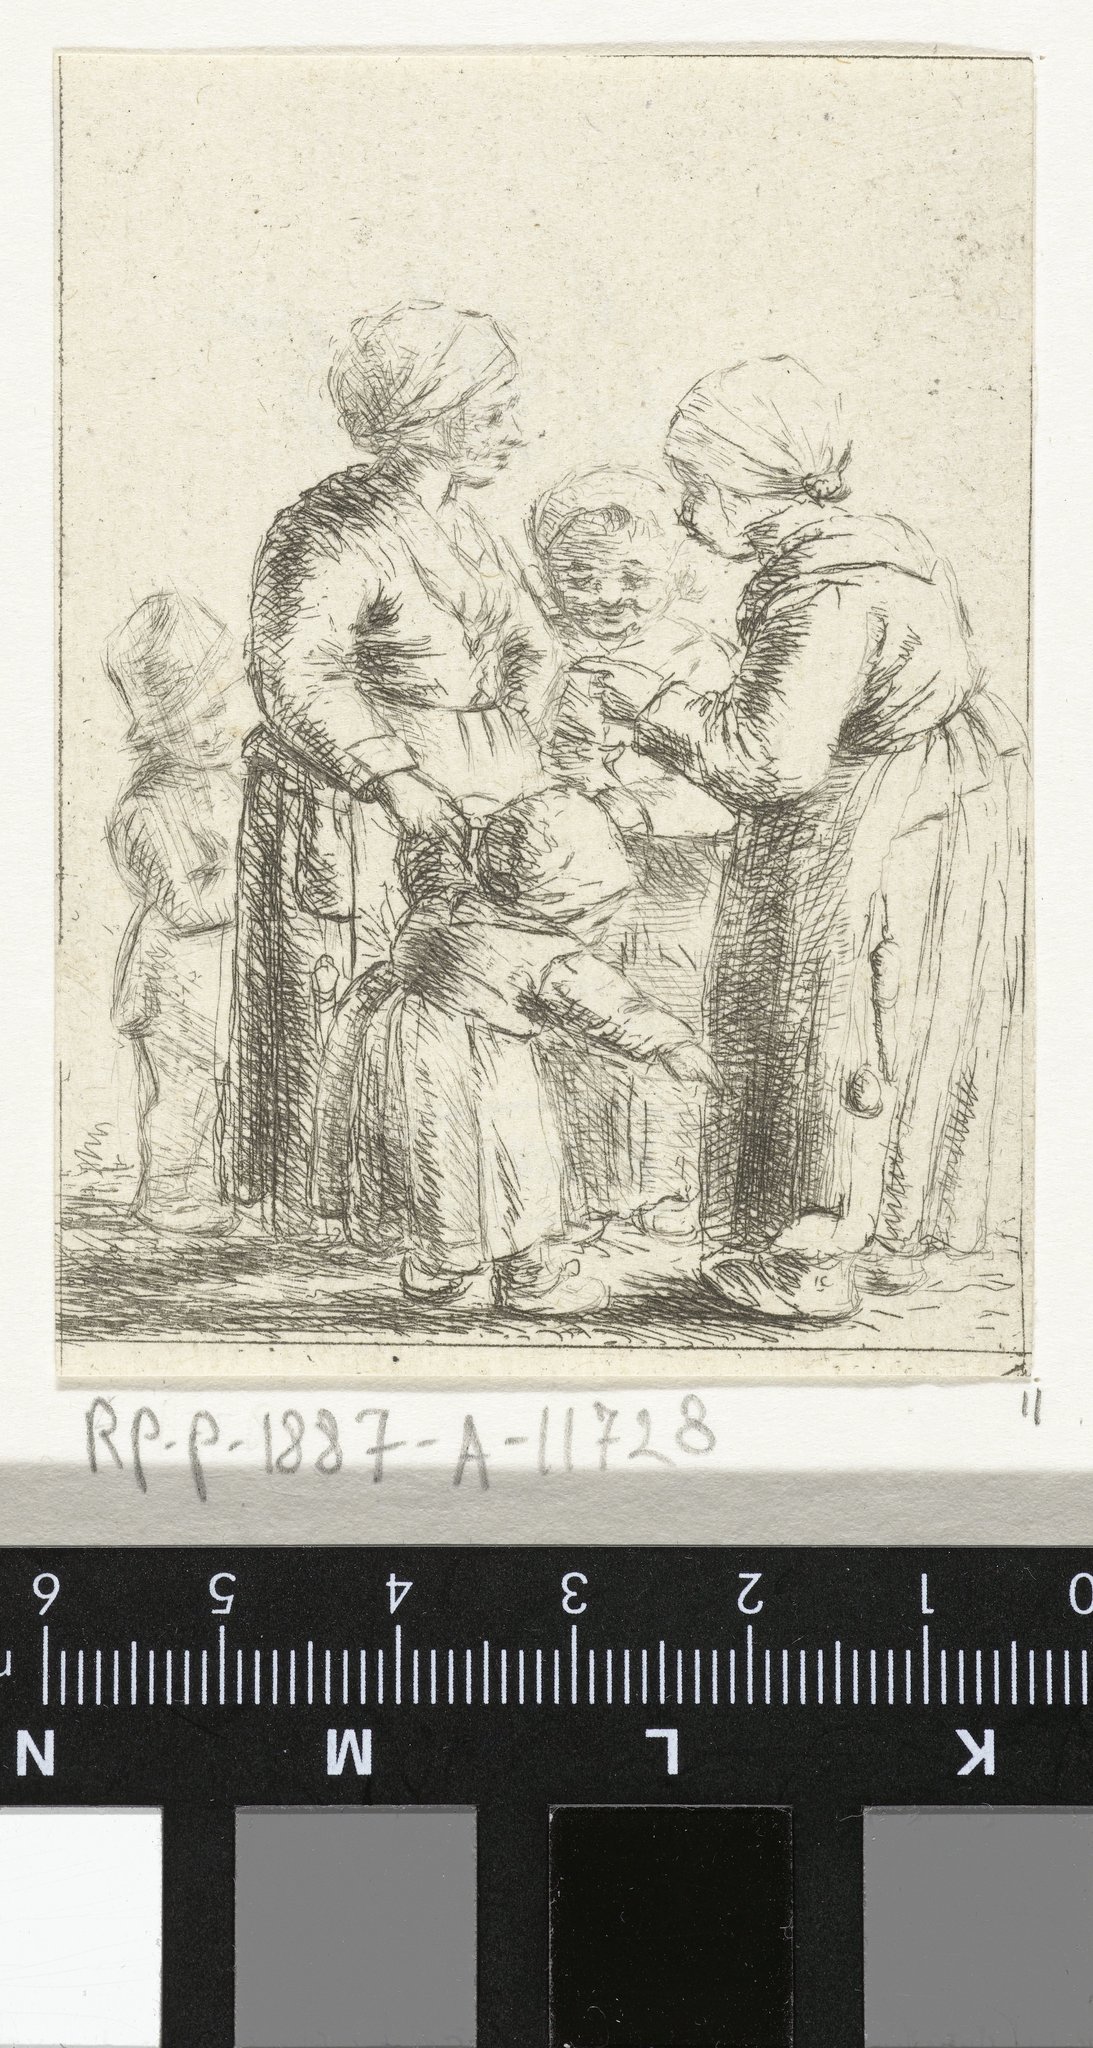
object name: print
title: Drie vrouwen in gesprek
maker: christina chalon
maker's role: draughtsman, print maker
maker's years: 1748-1808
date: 1758-1808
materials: paper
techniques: etching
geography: leiden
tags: human races; peoples; nationalities (+ women), mother and child(ren), woman and child(ren) (family group) (with number of children)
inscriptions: collector's mark: Lugt 2228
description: Drie vrouwen staan bij elkaar en zijn druk in gesprek. Een van de vrouwen heeft een kind aan de hand. Een ander kind verschuilt zich achter haar rok.